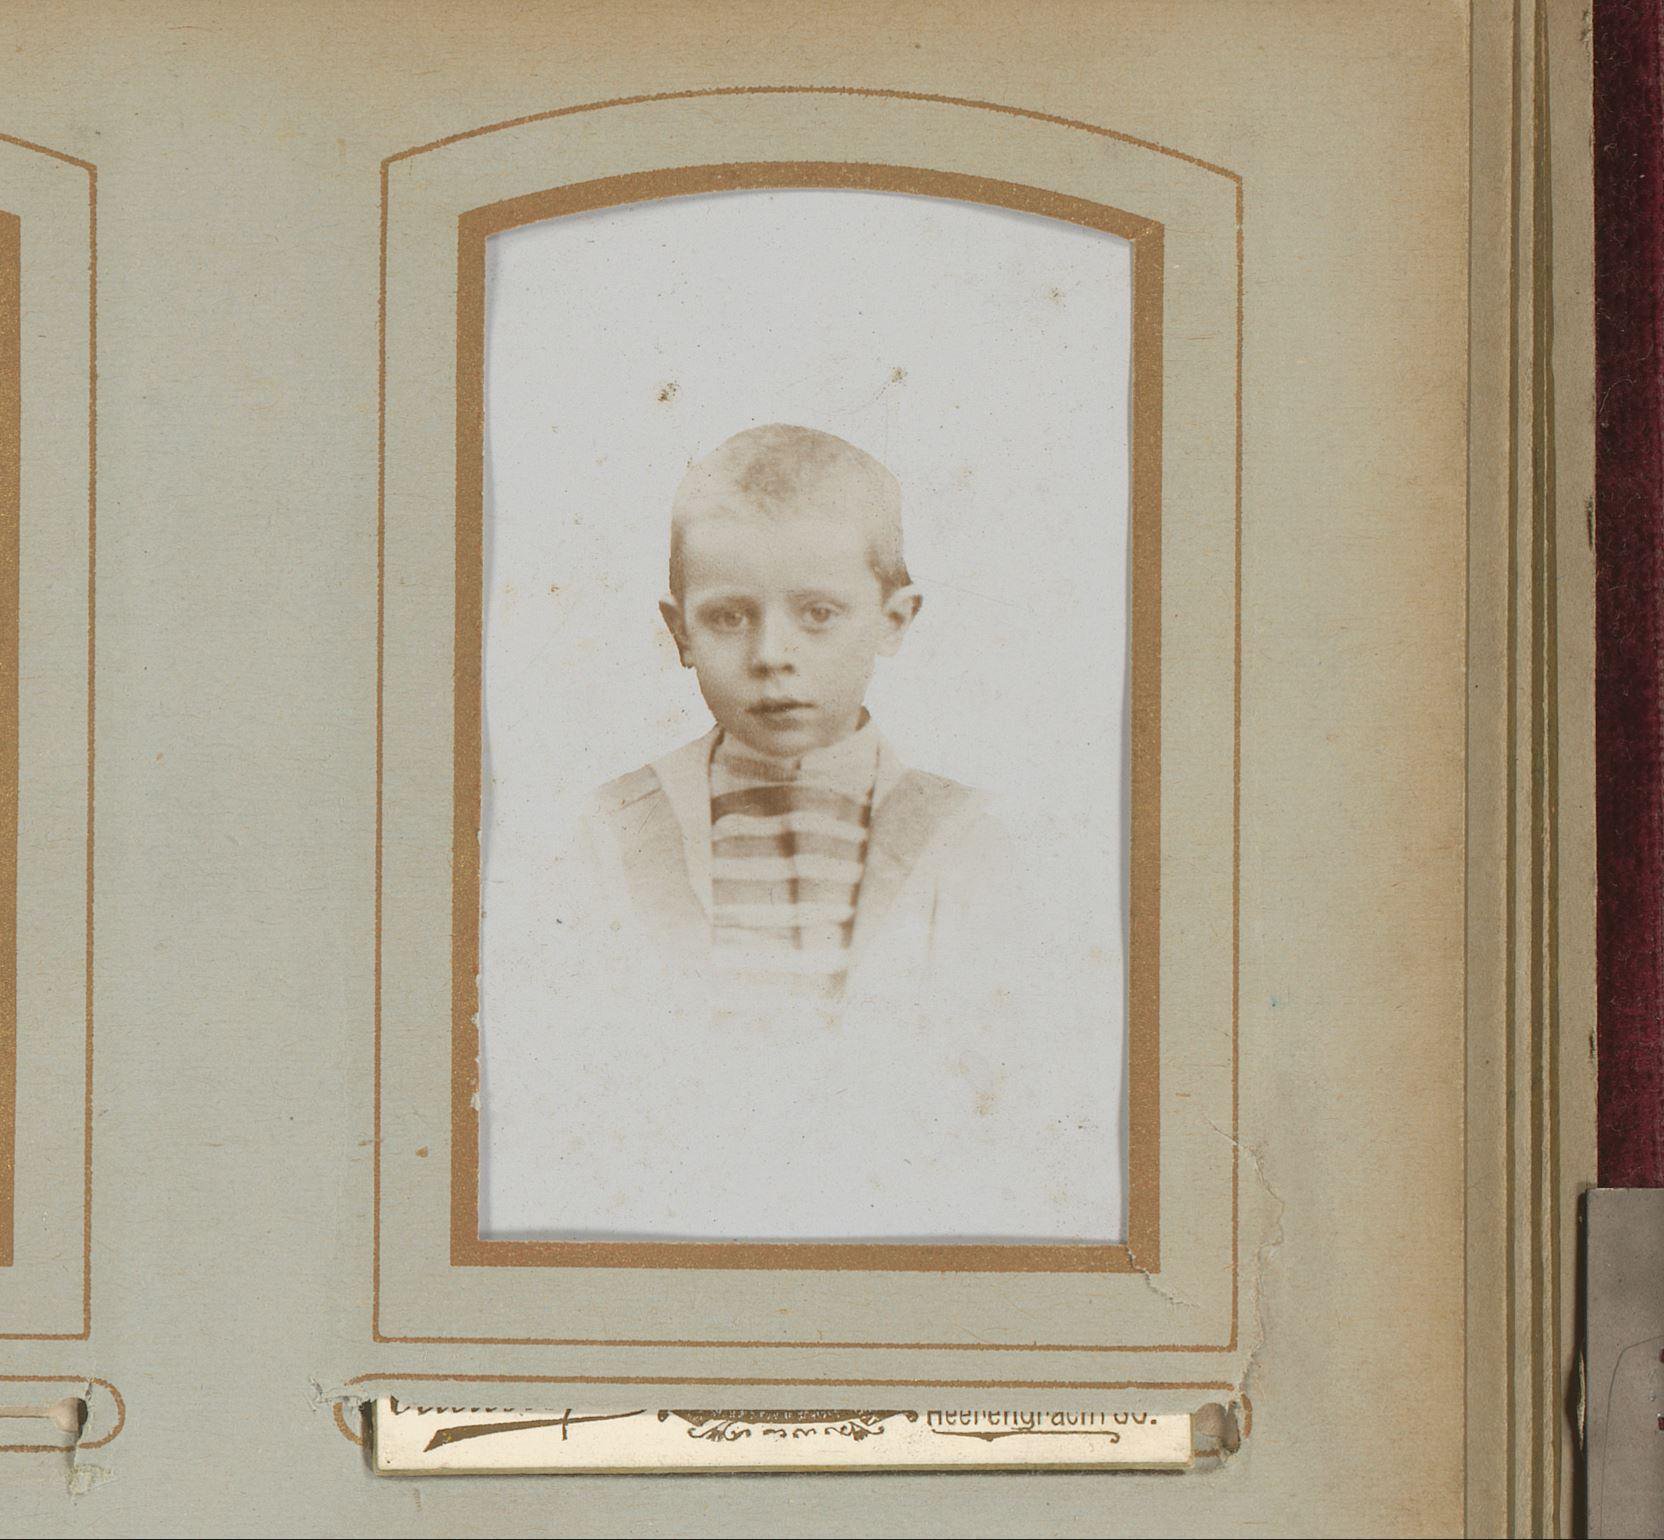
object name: album leaf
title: Portret van een jongen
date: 1892-1910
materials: cardboard, photographic support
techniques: collodion silver print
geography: amsterdam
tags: boy (child between toddler and youth)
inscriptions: inscription: ‘Prinsengracht No 458’, number: ‘5992’, inscription: ‘Atelier Herz/ Amsterdam/ Heerengracht 80/ Heerenstraat 4/ Prageer & Lojda, Berlin/ 41100’